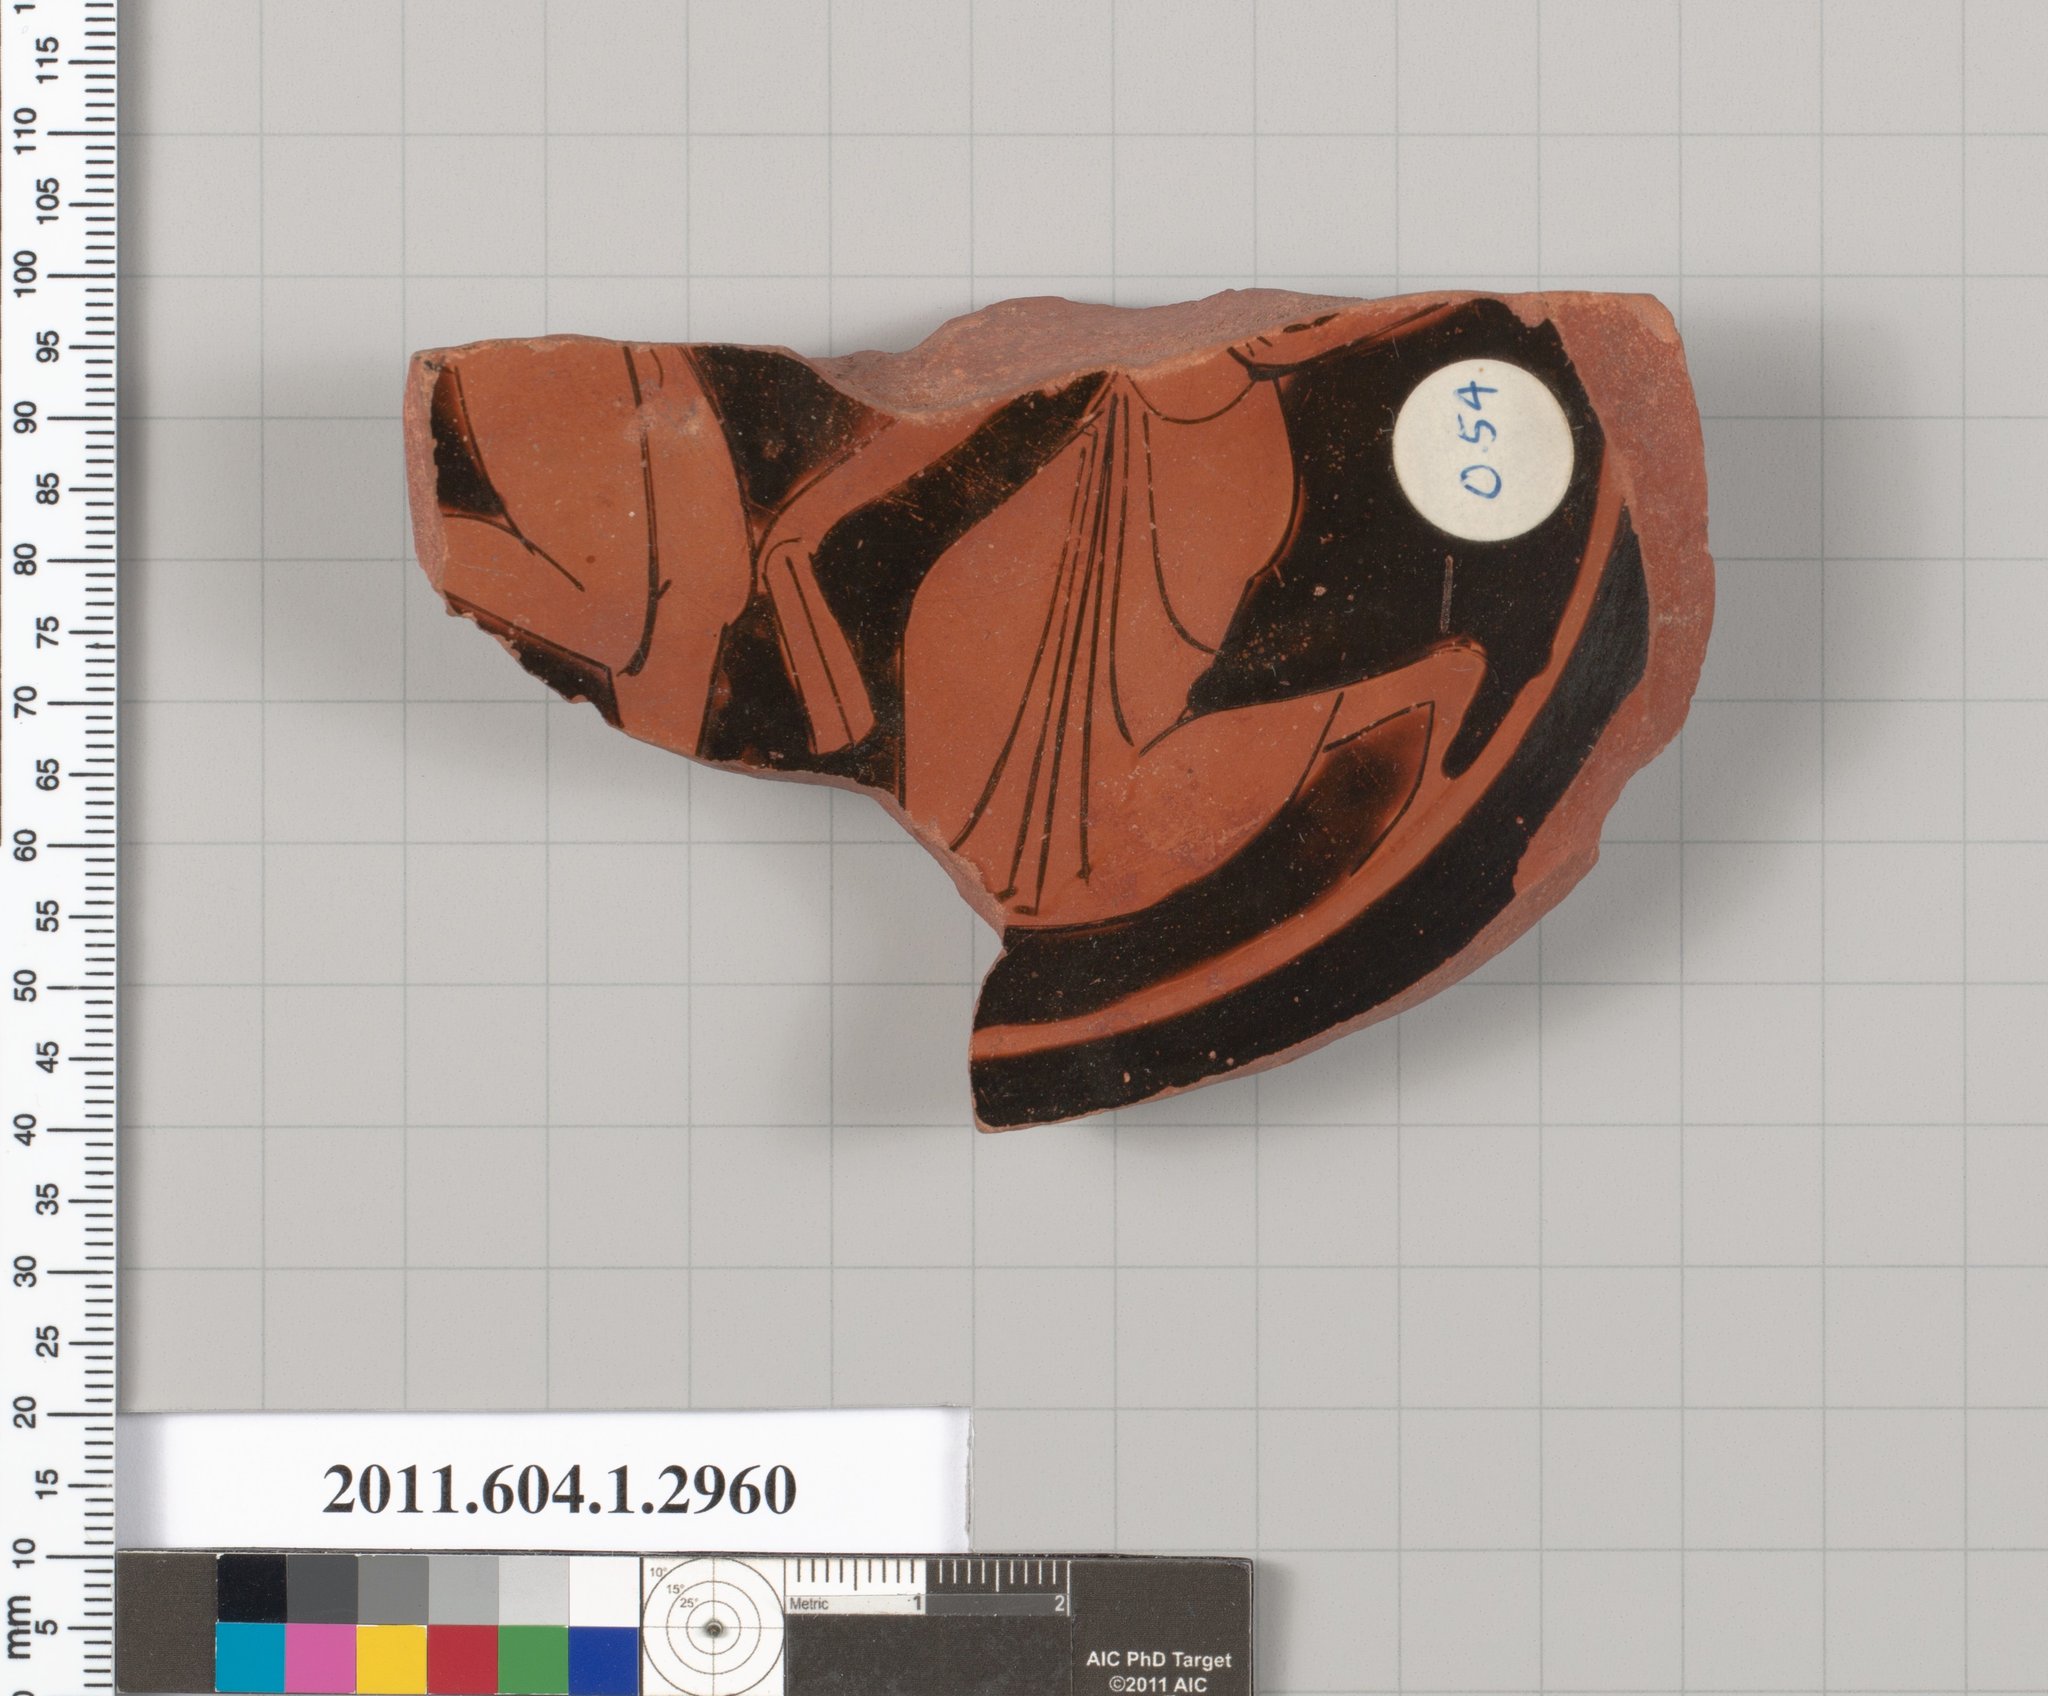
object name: kylix fragment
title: Terracotta fragment of a kylix (drinking cup)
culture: greek, attic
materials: terracotta